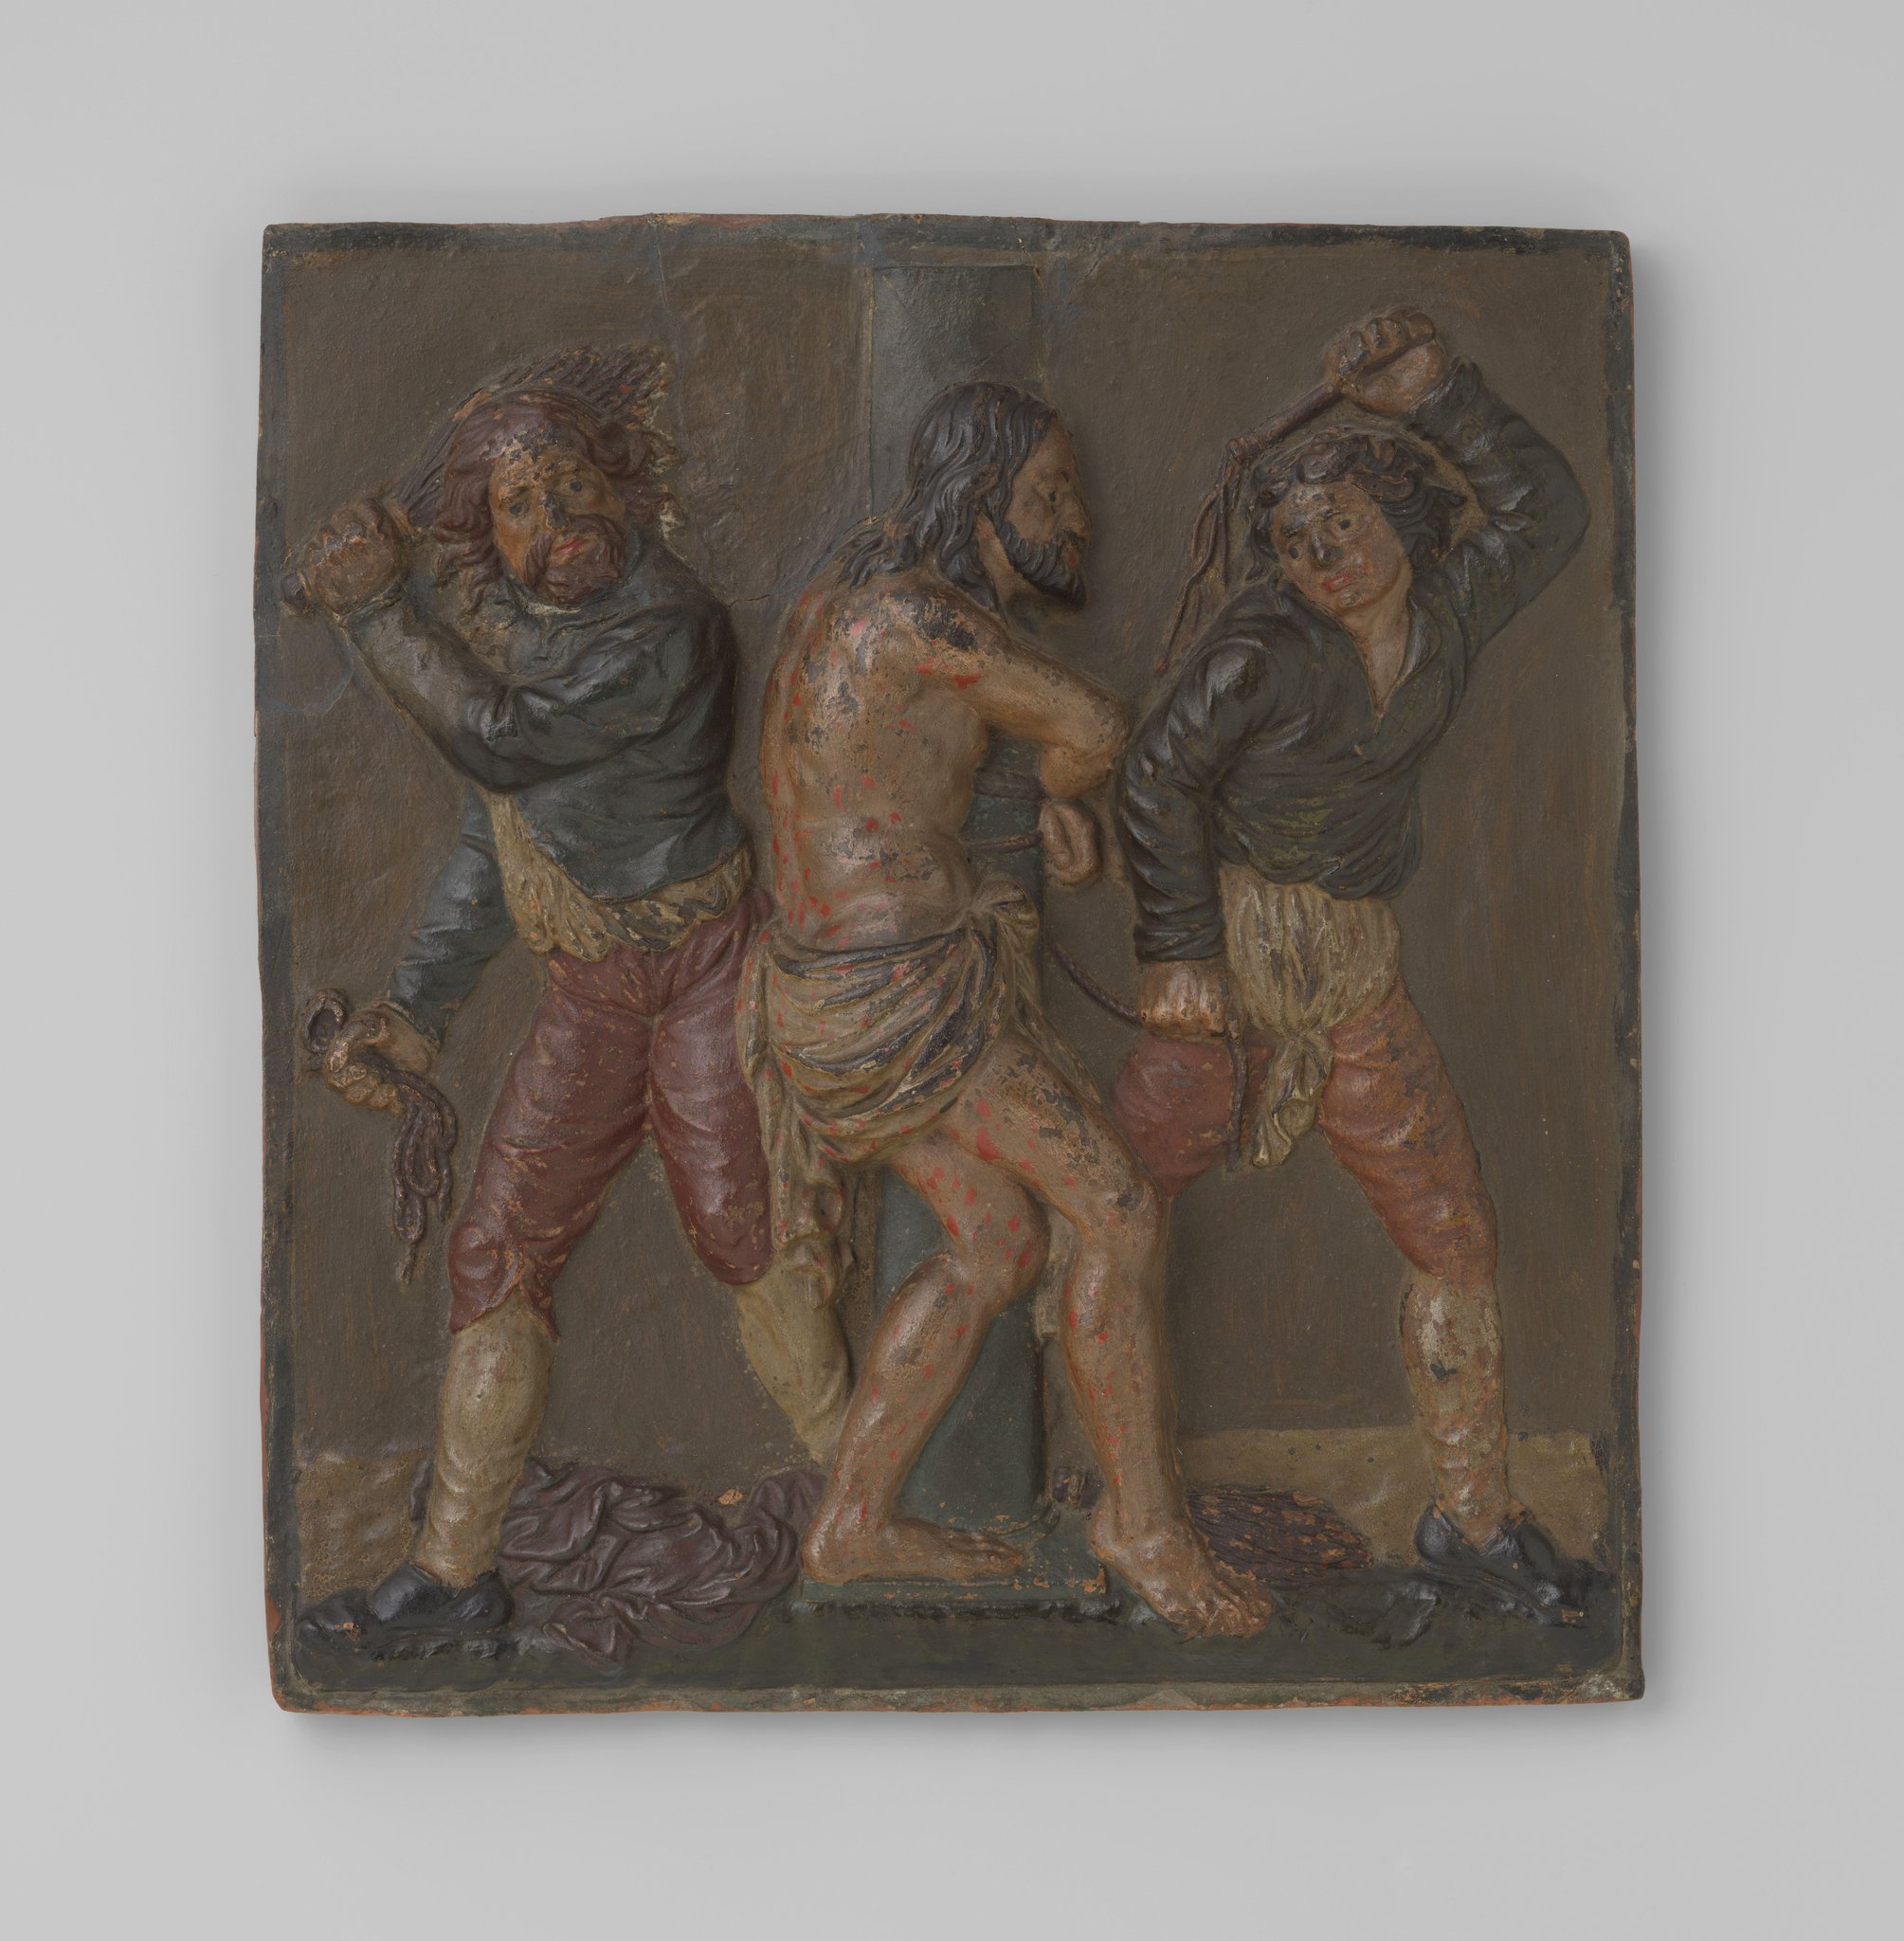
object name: relief sculpture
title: Geseling van Christus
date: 1630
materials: terracotta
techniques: polychromy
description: Terracotta reliëf met de geseling van Christus, die gebonden staat aan een pilaar en geflankeerd wordt door twee beulen, die hem met zwepen slaan. Het geheel is veelkleurig beschilderd.